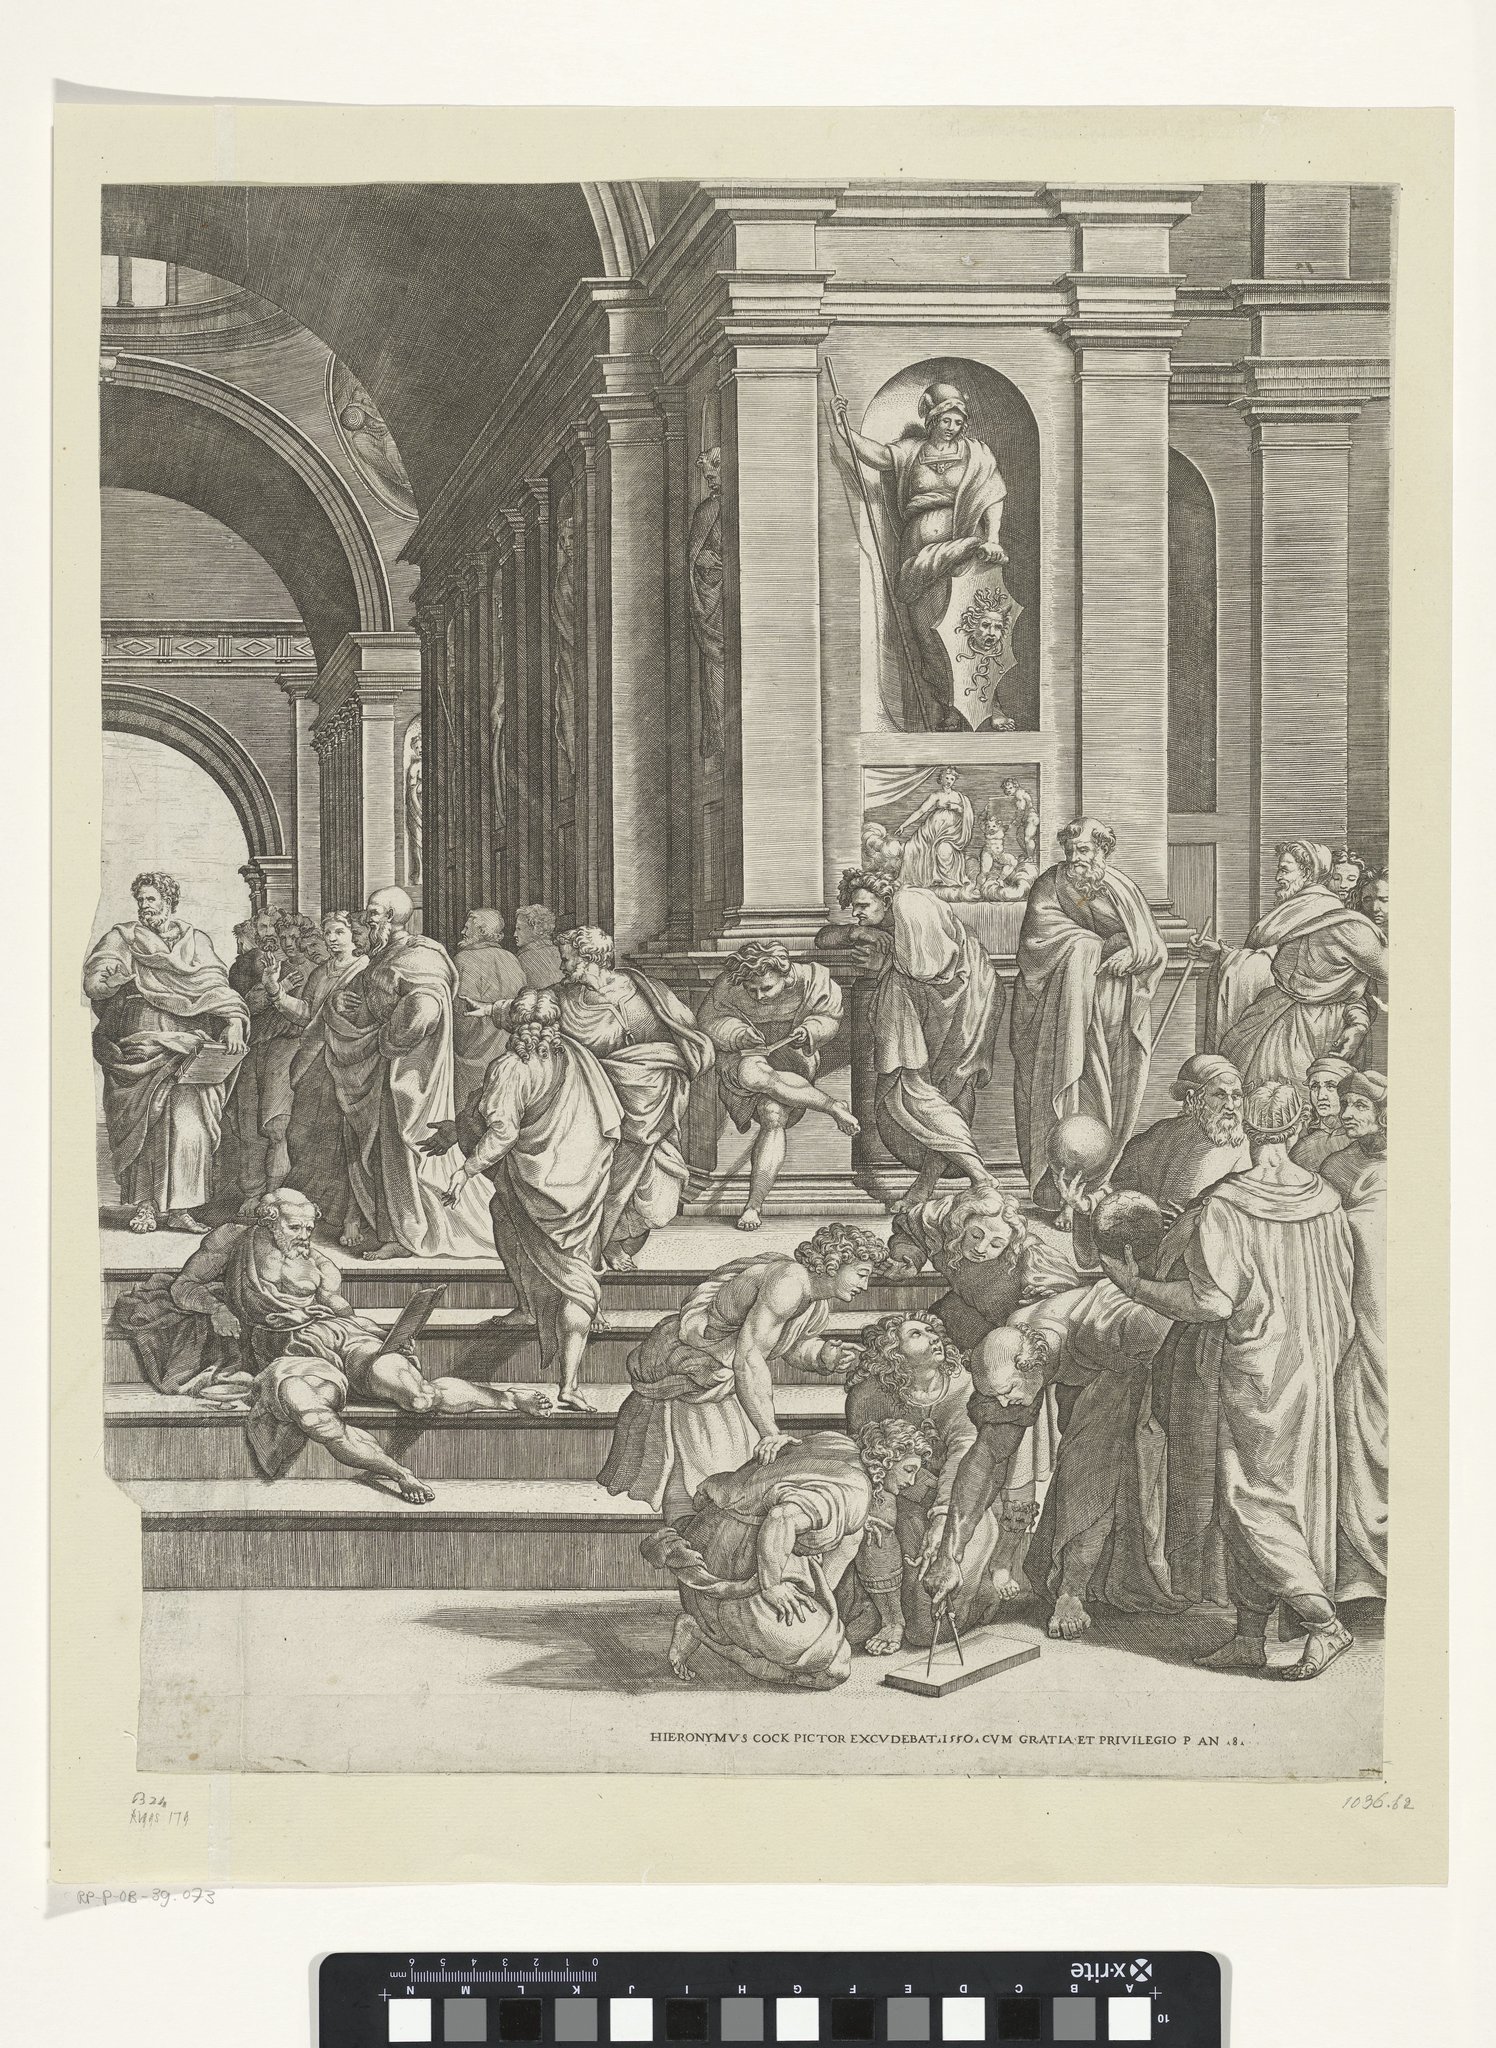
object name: print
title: De School van Athene (rechter deel)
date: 1530-1582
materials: paper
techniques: engraving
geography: italy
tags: scholar, philosopher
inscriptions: collector's mark: Lugt 240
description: Het fresco 'De School van Athene' door Rafaël in de Stanza della Segnatura in het Apostolisch paleis in het Vaticaan. Het toont een filosofenschool of agora waar beroemde Griekse filosofen en geleerden, zoals Aristoteles, Plato en Socrates, in groepjes staan te praten. Het is een uitbeelding van de filosofie en haar rationele zoektocht naar de Waarheid.